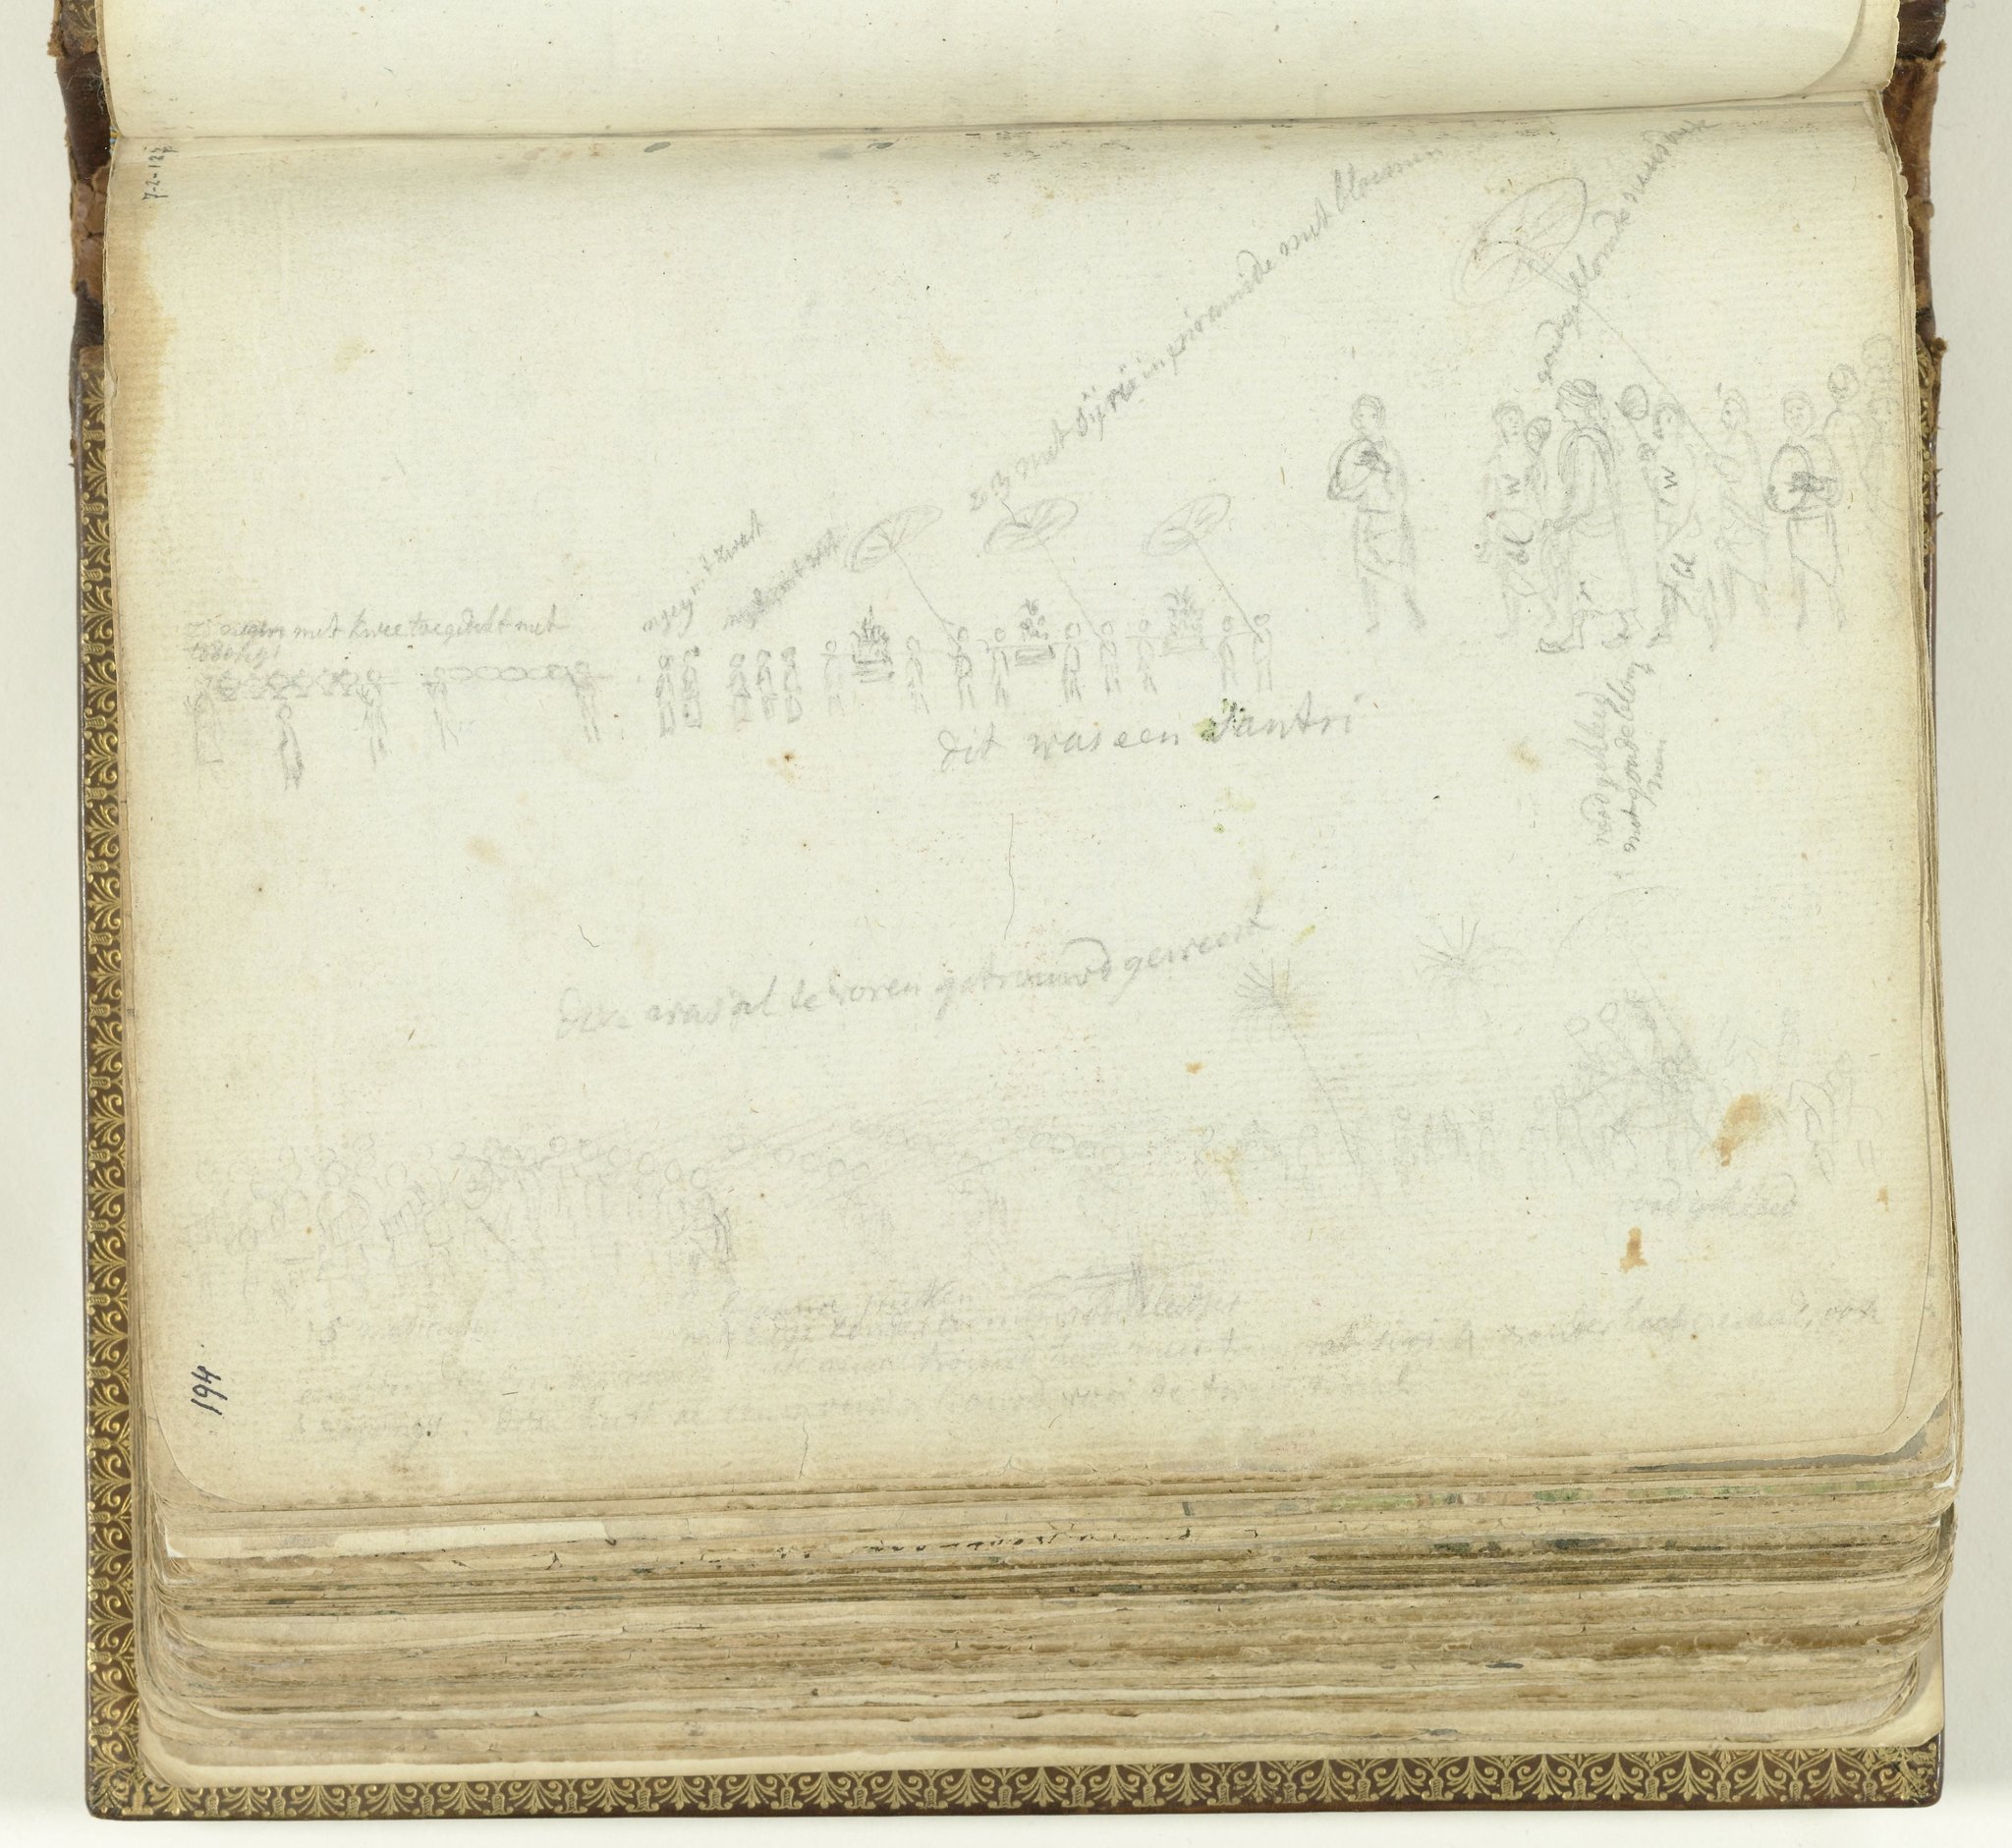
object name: drawing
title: Bruiloftsstoet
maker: jan brandes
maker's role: draughtsman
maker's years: 1743-1808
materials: paper, pencil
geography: jakarta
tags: (civil) marriage ceremonies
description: Schets met opschrift van een stoet mensen met parasollen en lansdragers. Onderdeel uit het schetsboek van Jan Brandes, dl. 2 (1808), p. 194.